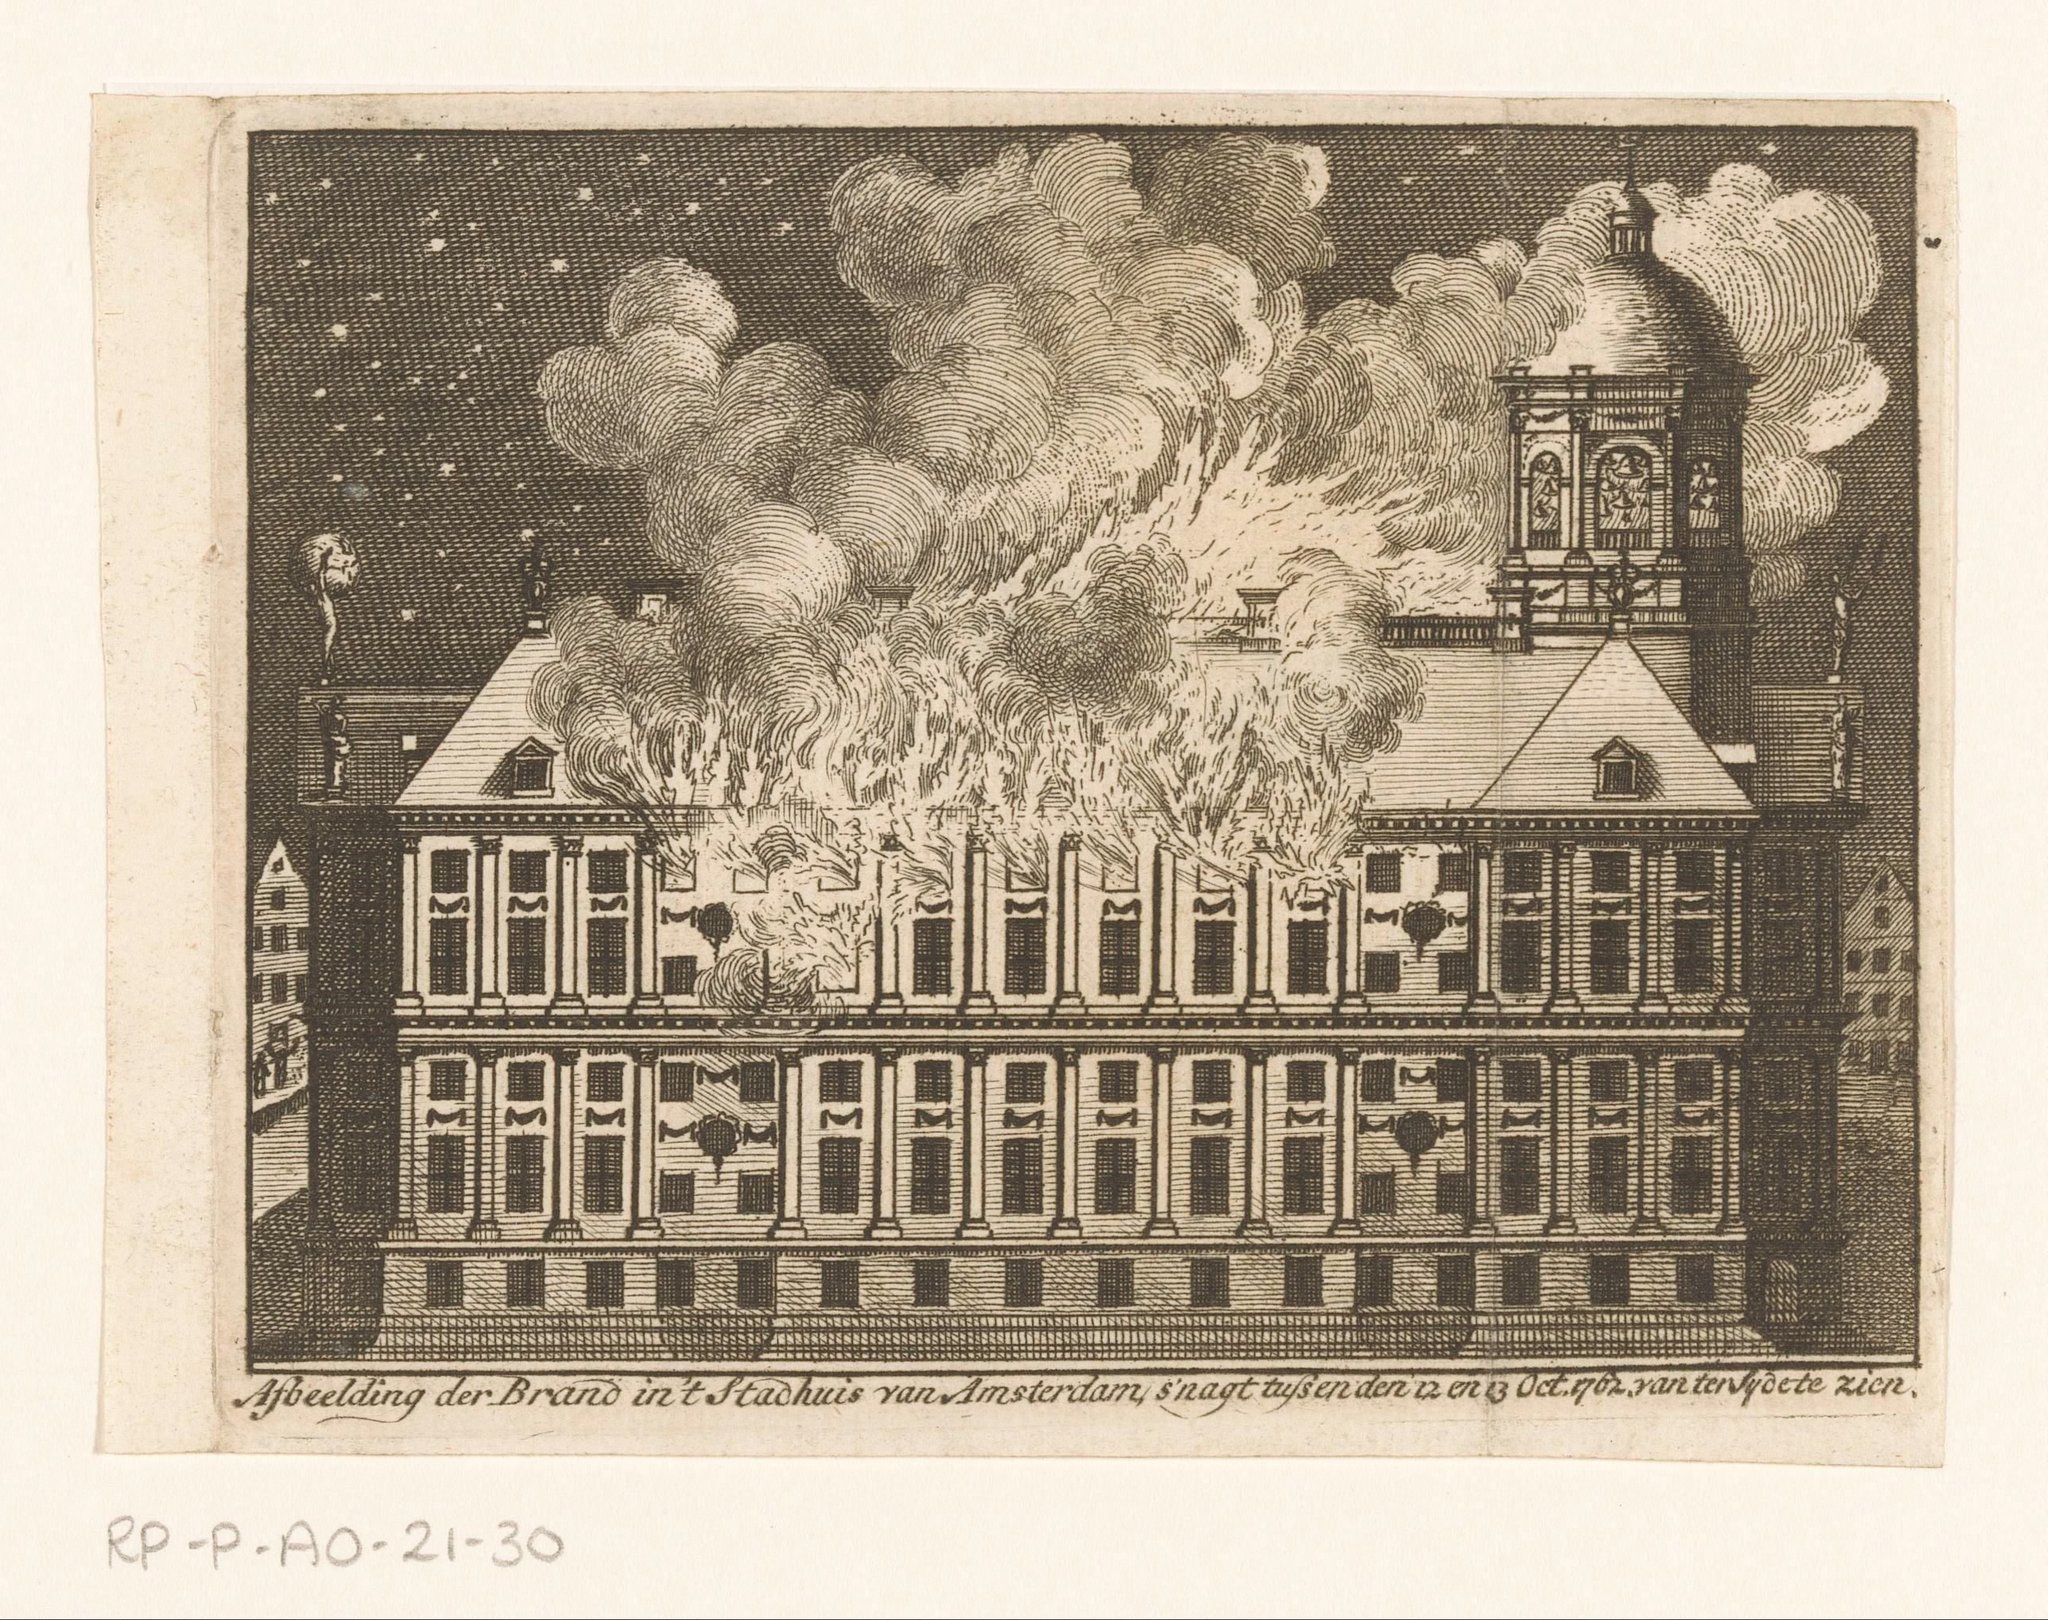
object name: print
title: Afbeelding der Brand in 't Stadhuis van Amsterdam, s' nagt tussen den 12 en 13 Oct. 1762. van ten syde te zien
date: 1762-1763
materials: paper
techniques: engraving, etching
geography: amsterdam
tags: on fire, ablaze, townhall, fire-fighting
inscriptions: collector's mark: Lugt 2228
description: Prent ook gebruikt in: Nieuwe volledige en nuttige altoosdurende societeit almanak der geleerden. Voor den Jaare MDCCLXIII (...). Amsterdam: Steven Jacobus Baalde, 1763.